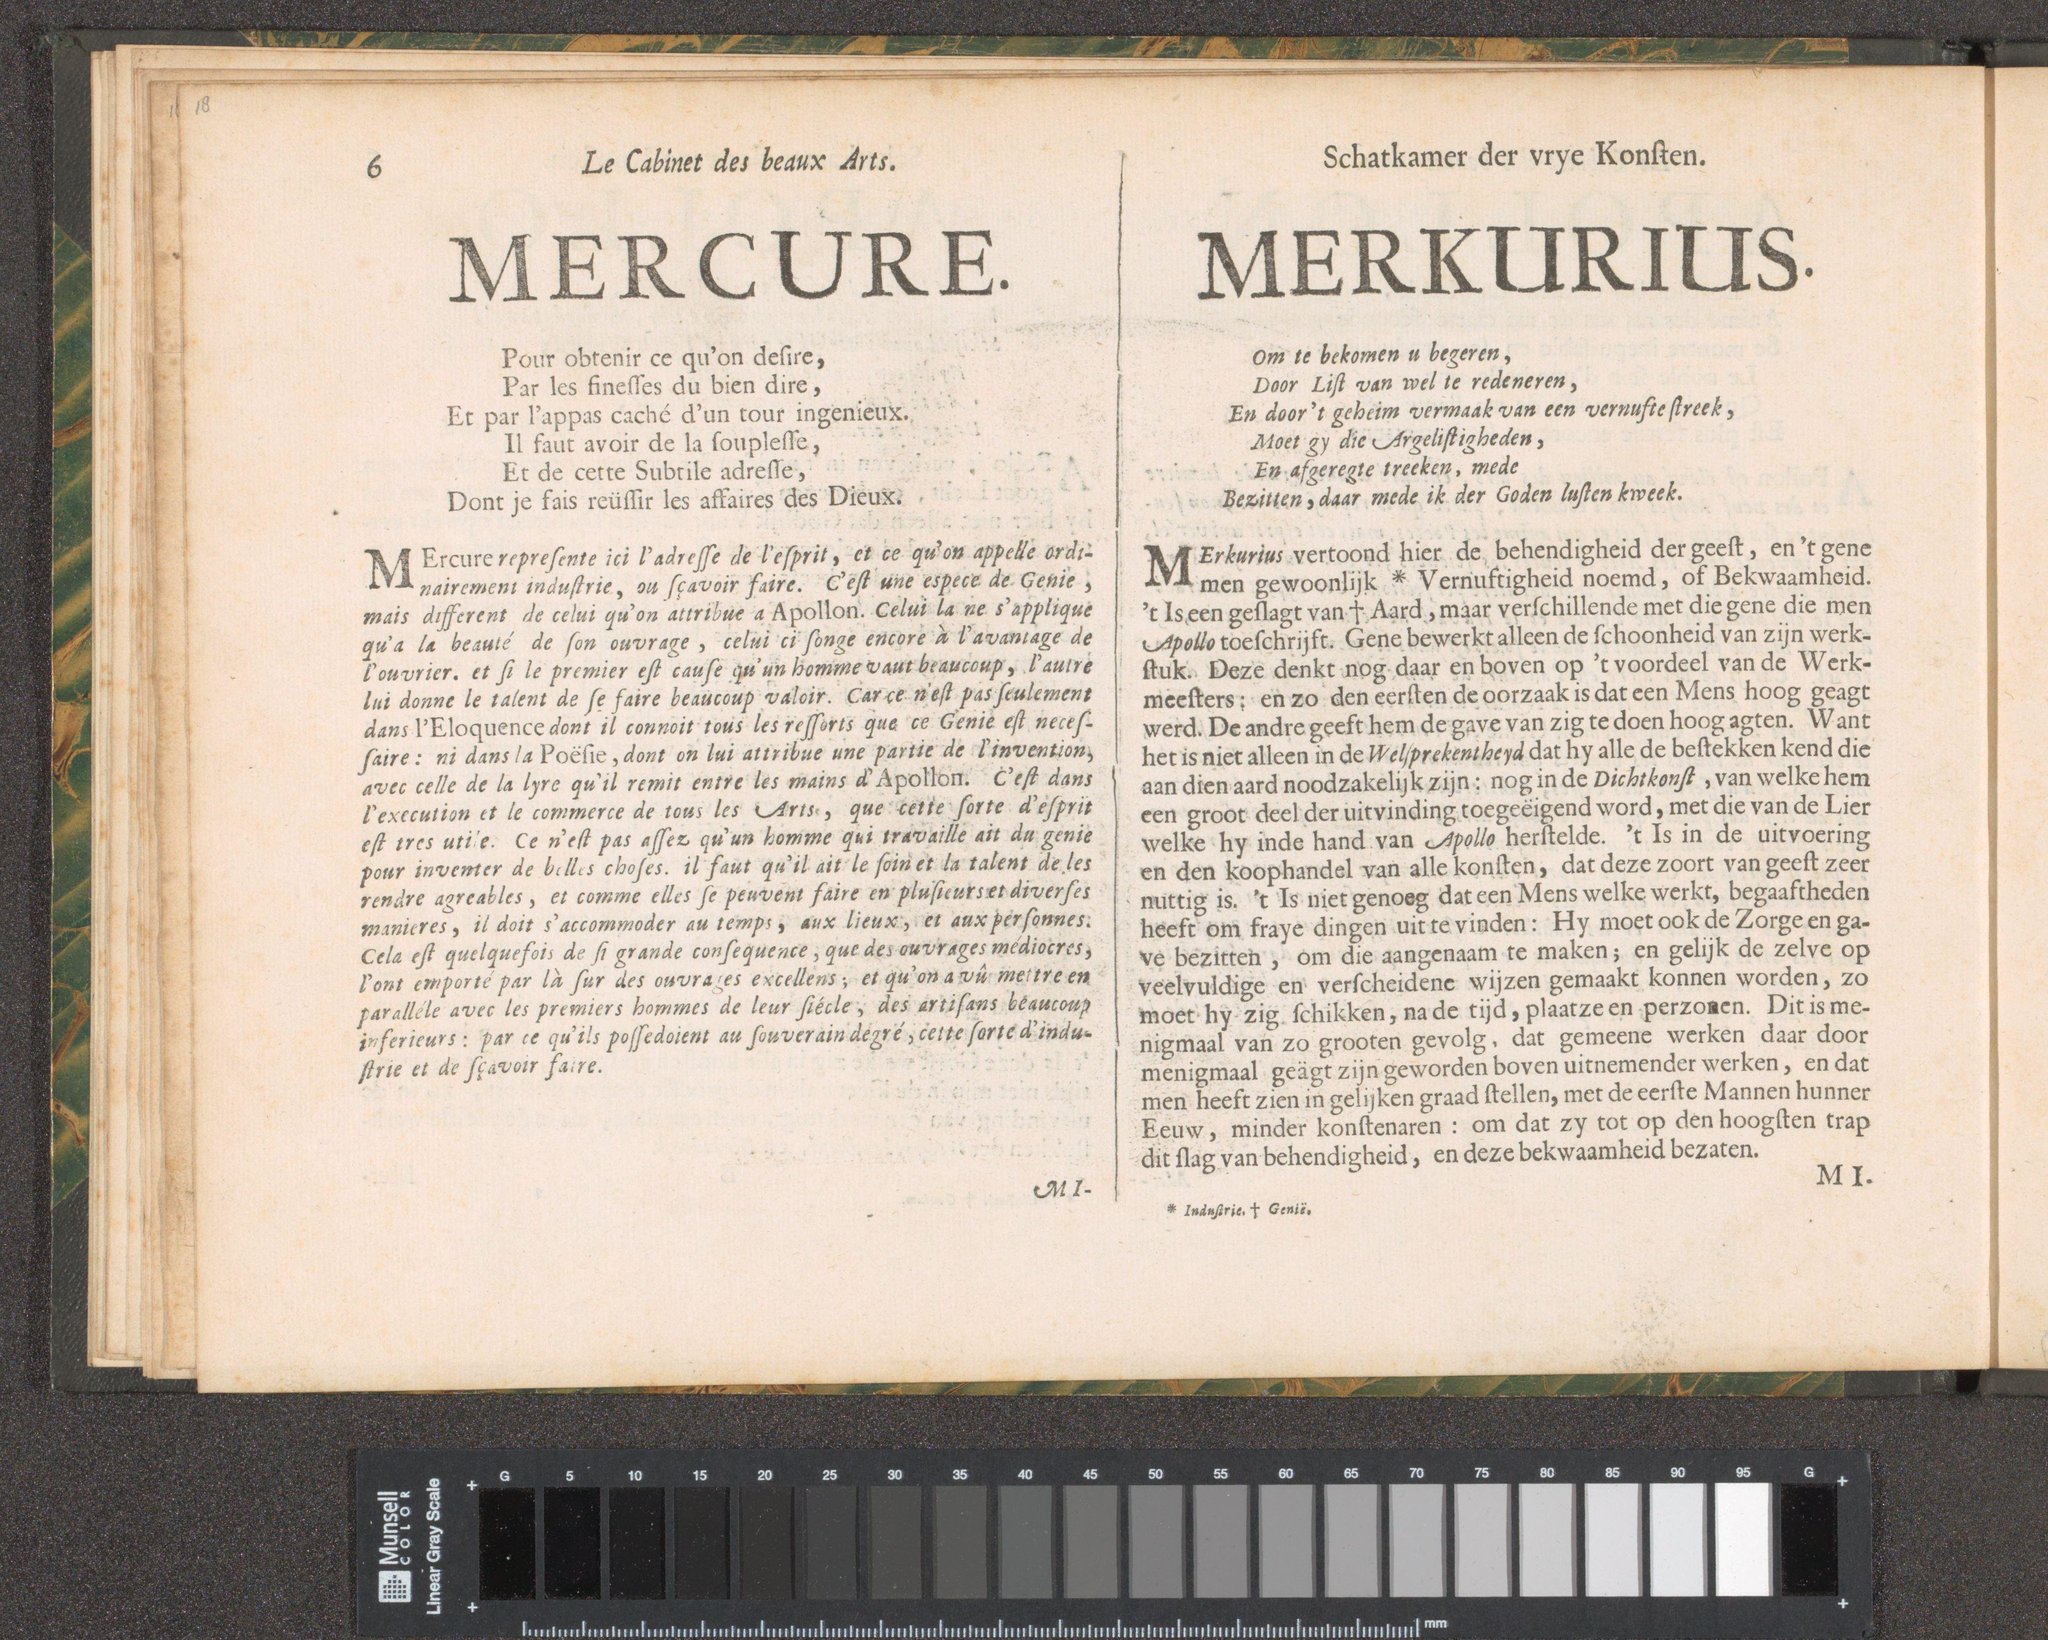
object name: text sheet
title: Mercure / Merkurius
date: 1693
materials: paper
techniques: letterpress printing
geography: amsterdam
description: Verklaring van de prent met de voorstelling van Mercurius in het Frans en het Nederlands, pagina 6. Tekstblad maakt deel uit van een album.